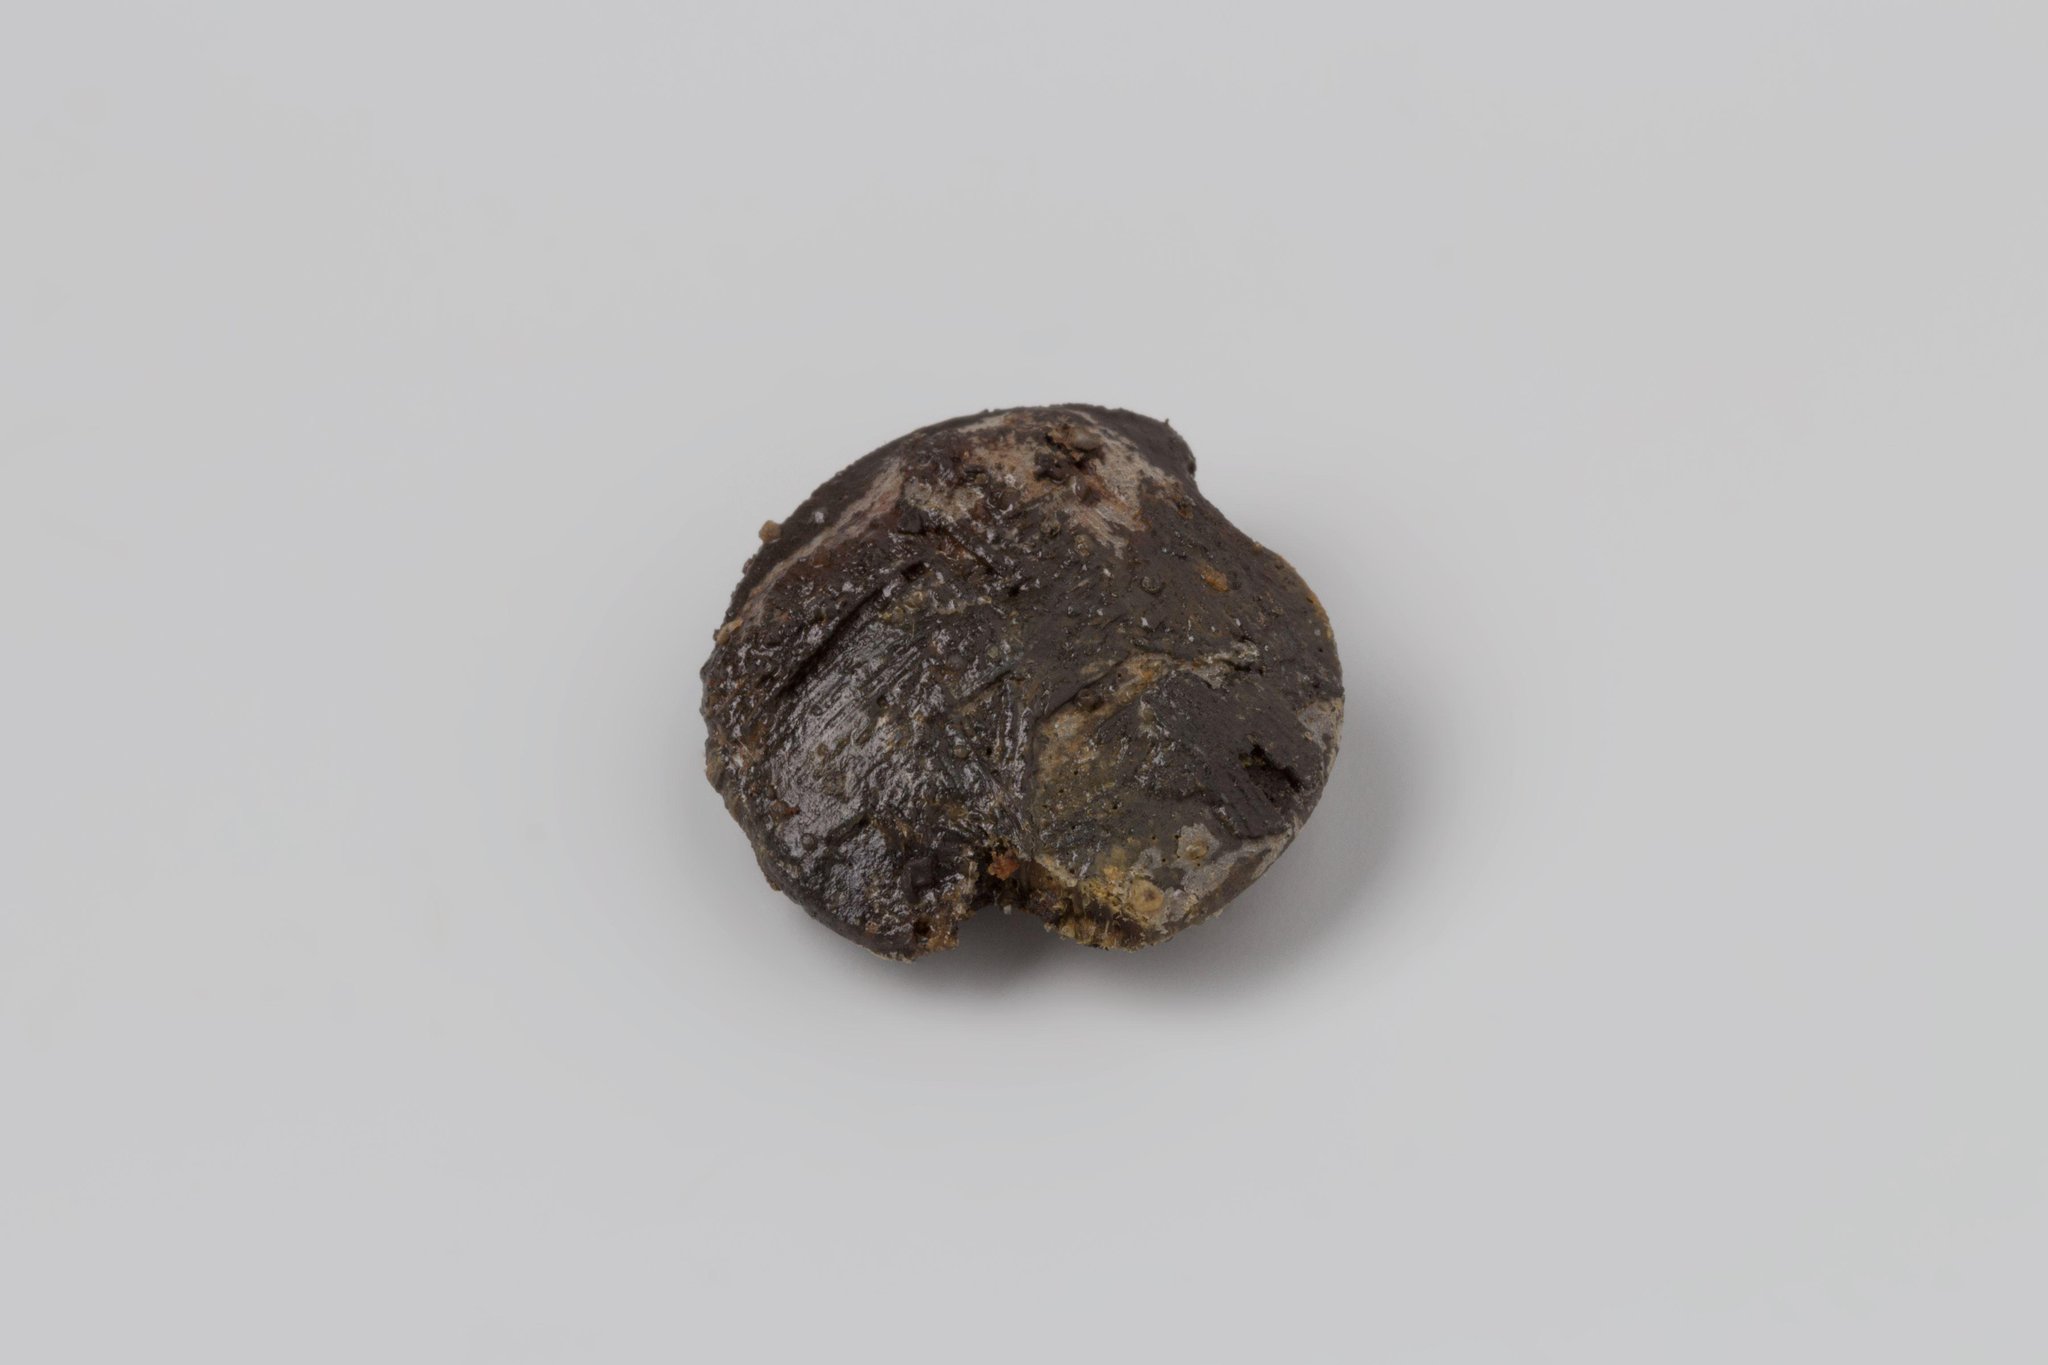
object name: button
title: Knoop uit het wrak van de Oost-Indiëvaarder 't Vliegend Hart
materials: wood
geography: middelburg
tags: 't vliegend hart (schip), verenigde oostindische compagnie